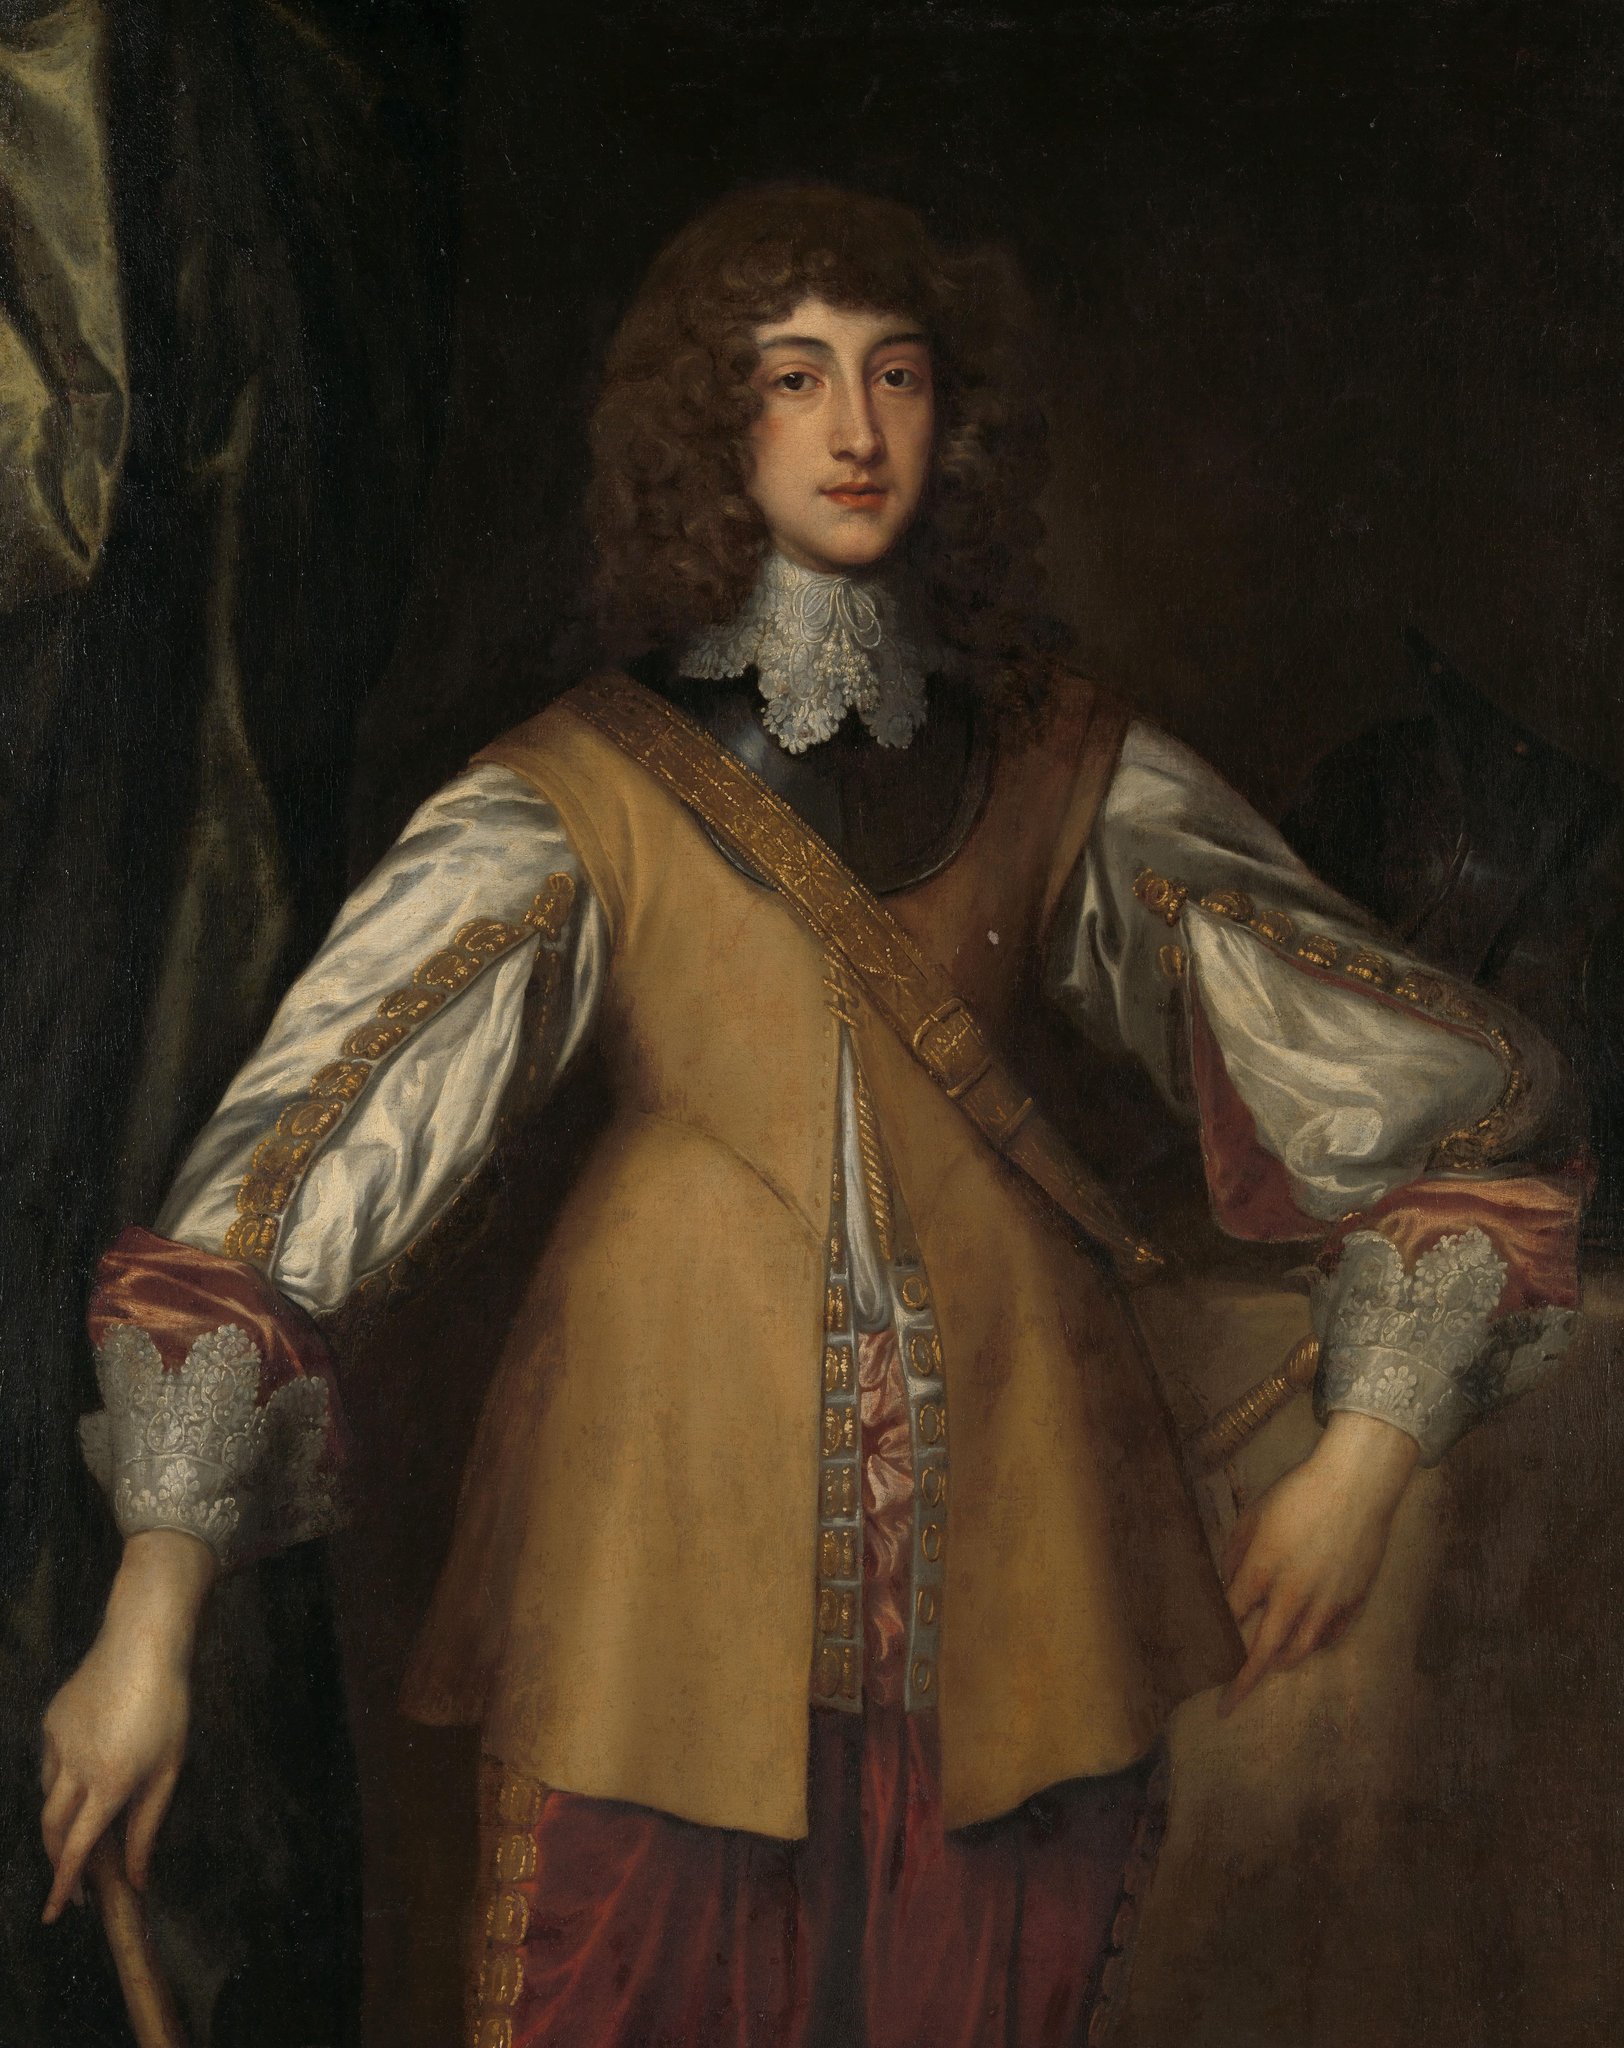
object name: painting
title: Portrait of Rupert (1619-1682), Prince-Palatine of the Rhine, in Combat Dress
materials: canvas, oil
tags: prague, london, painter, print maker, prinz ruprecht, historical persons, netherlands, germany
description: Portret van Prins Ruprecht, paltsgraaf aan de Rijn. Kniestuk, staande met commandostaf in de rechterhand. Kopie naar het origineel in Engeland.